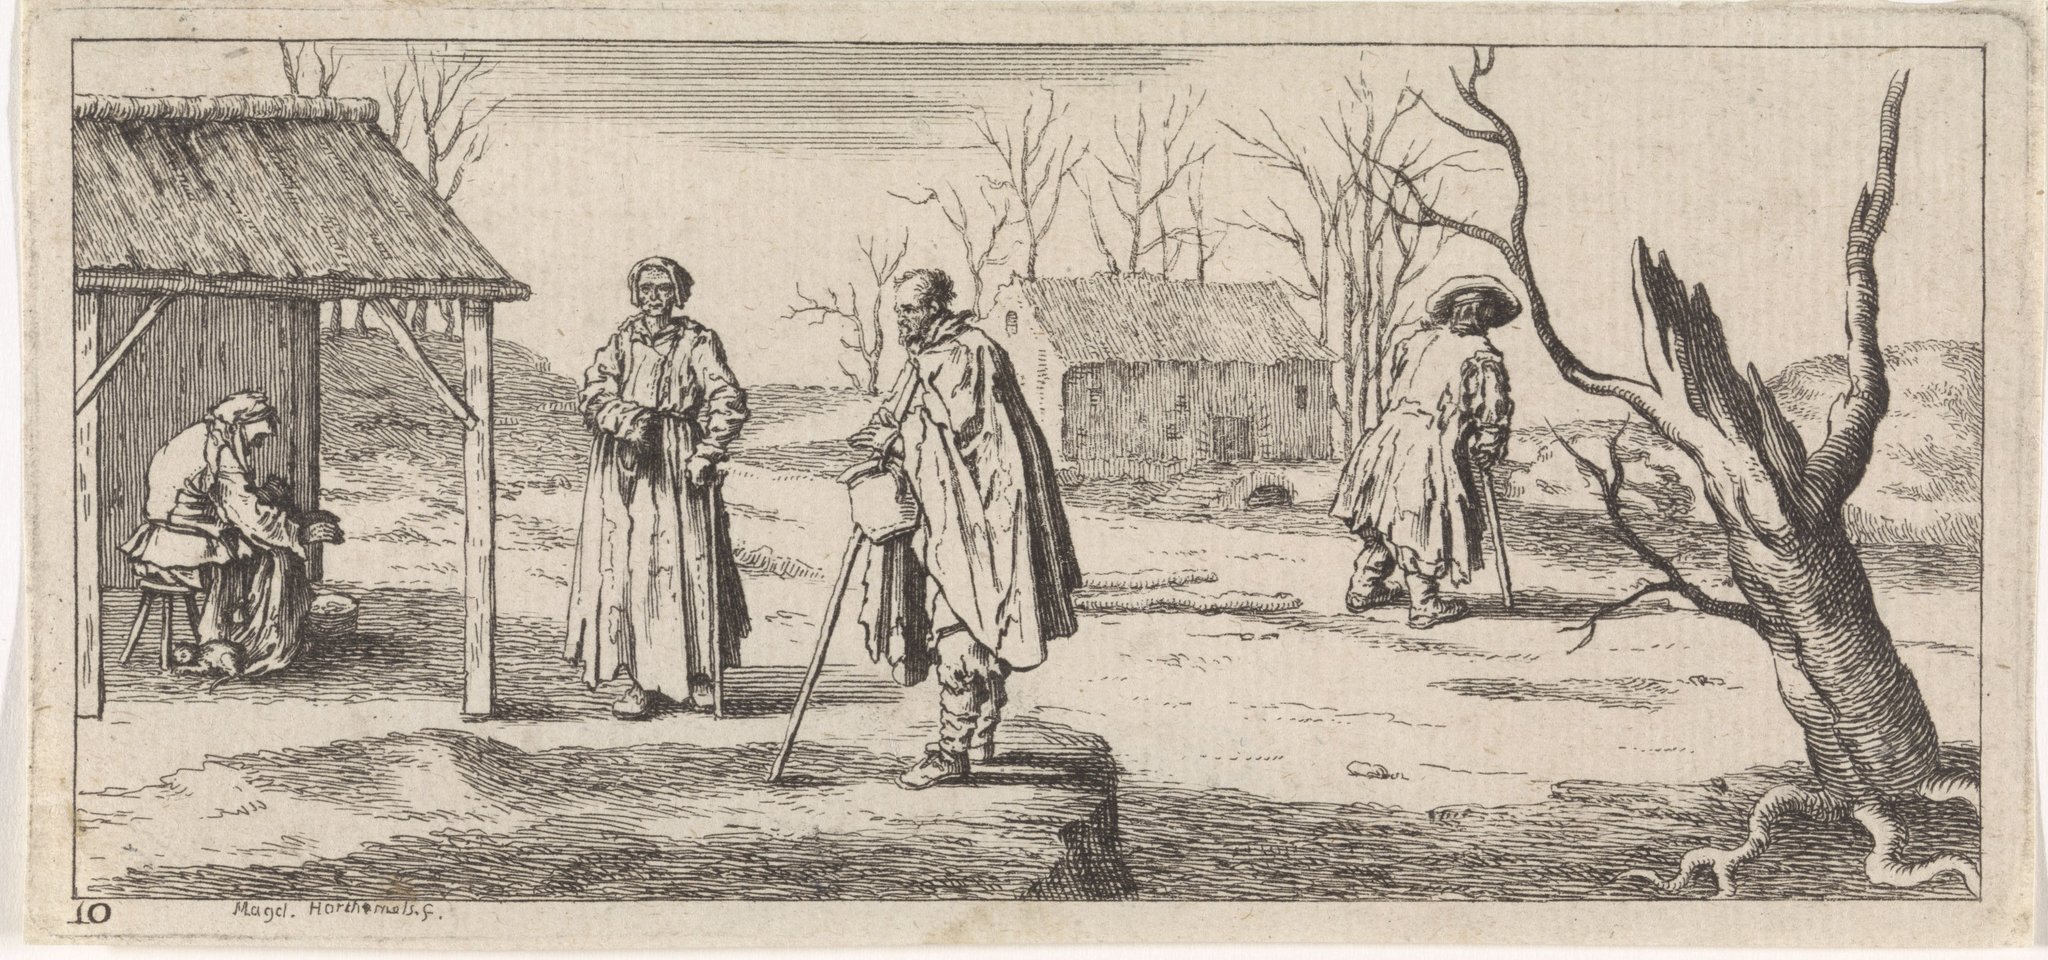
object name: print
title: Vier armen in een landschap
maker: louise magdeleine horthemels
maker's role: print maker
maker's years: 1686-1767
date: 1696-1767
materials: paper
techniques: etching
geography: paris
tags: person with a physical disability, disabilities, deformations, the poor, trees (+ plants used symbolically)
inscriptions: collector's mark: Lugt 2228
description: Landschap met bladerloze bomen en vier arme mensen. Links onder een afdak zit een vrouw die zich warmt aan een vuurtest. In het midden een bedelaar met een kan. Bij hem loopt een vrouw, leunend op een stok. Rechts een man op krukken. Linksonder gemerkt: 10.